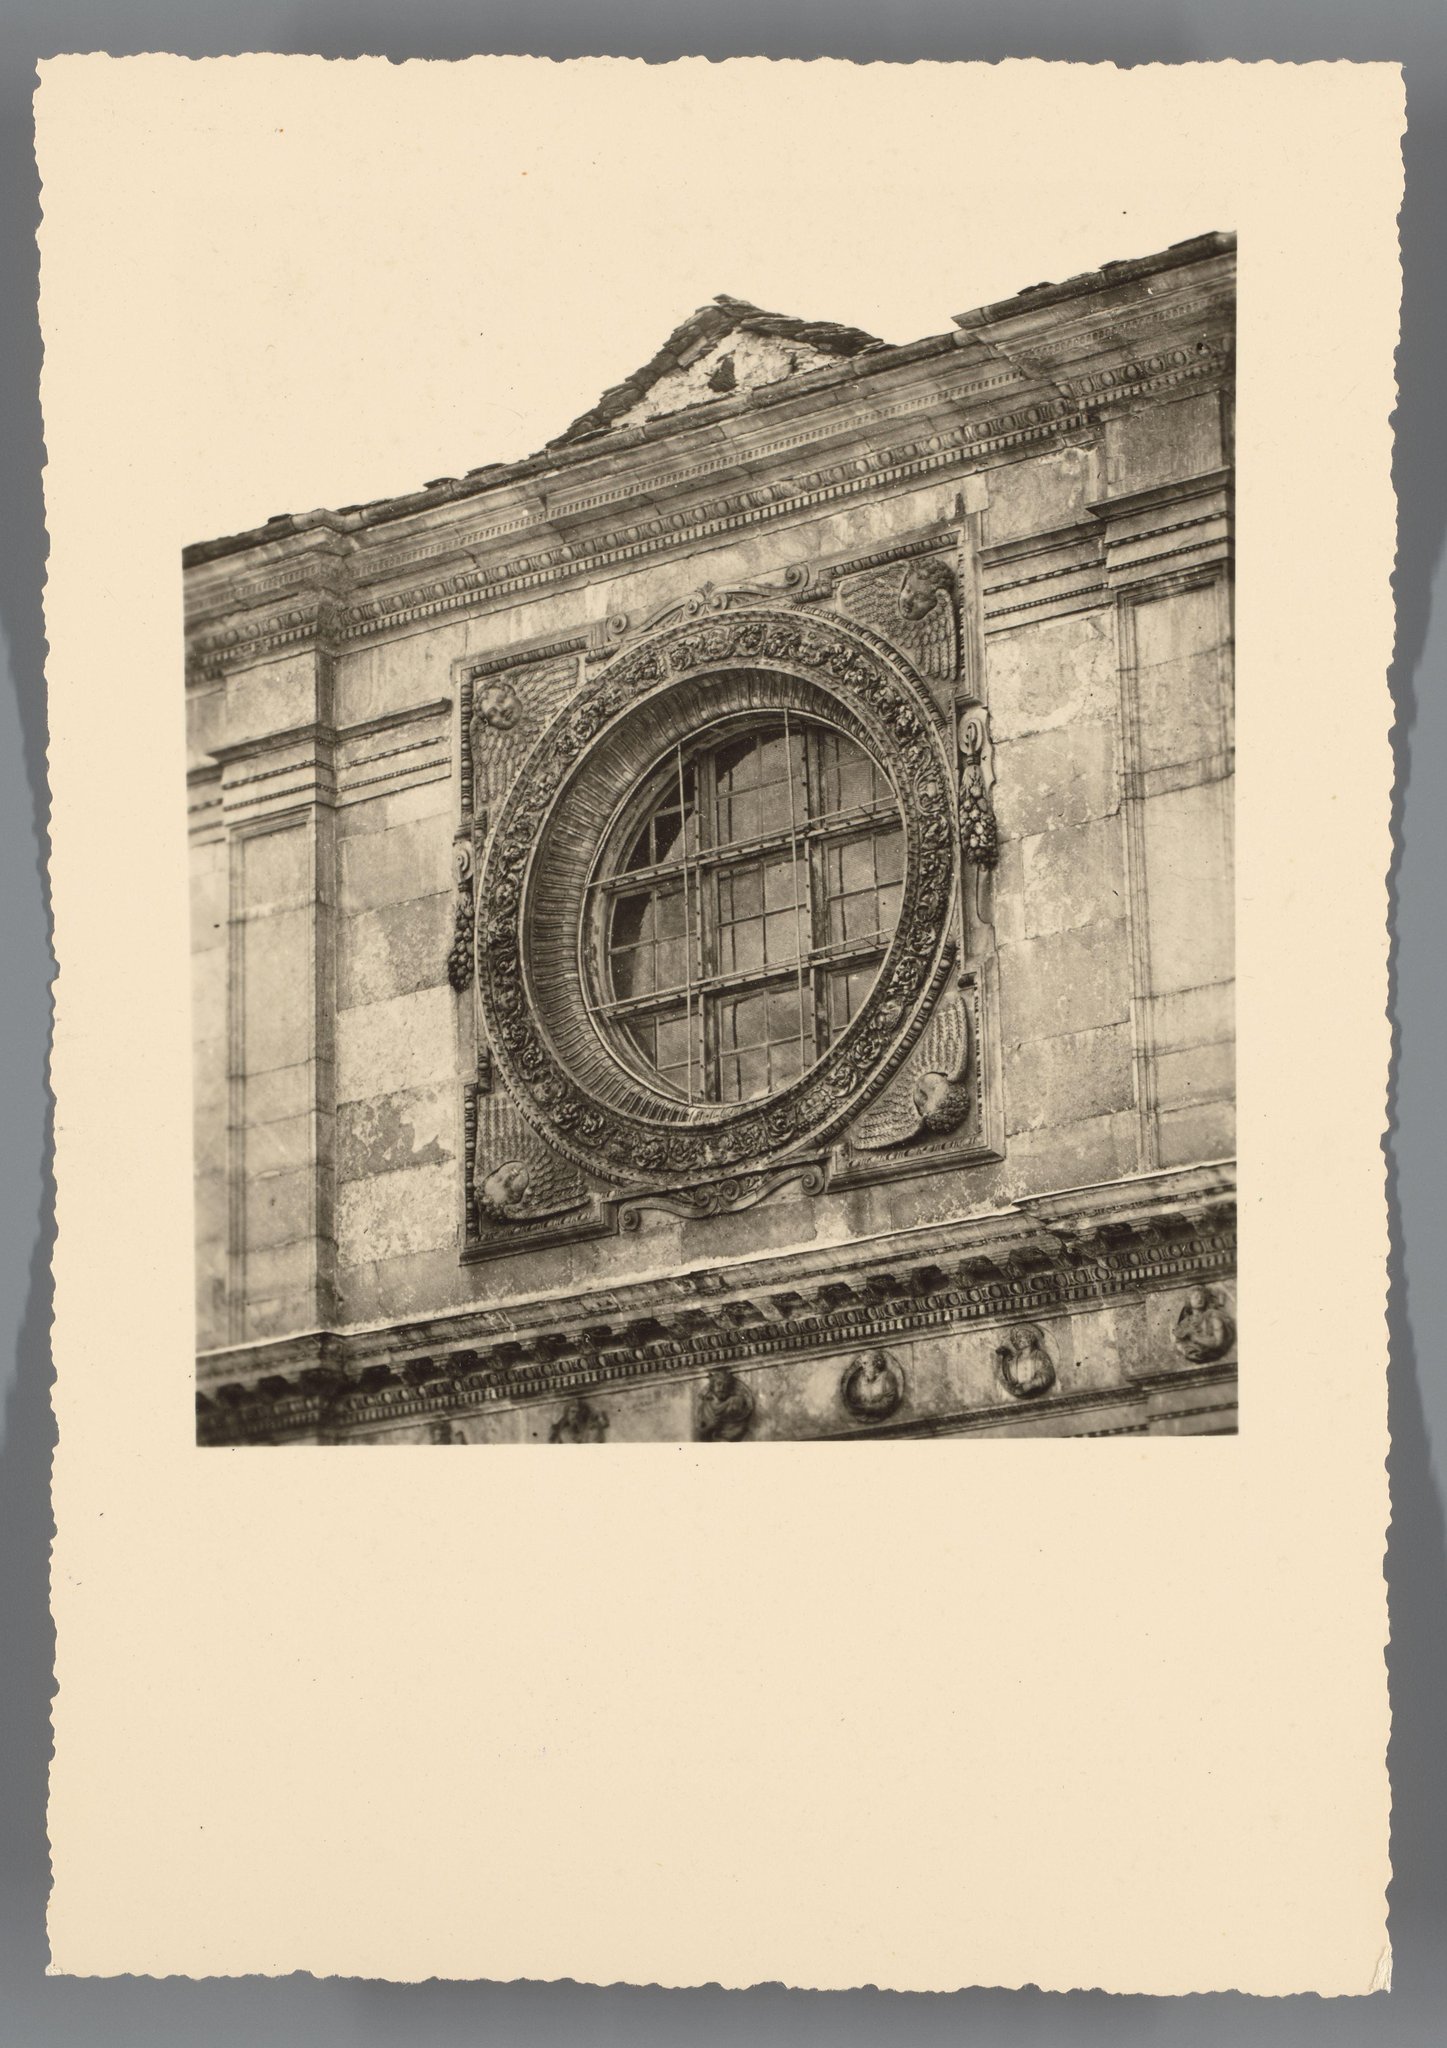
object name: photograph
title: Italië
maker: Anonymous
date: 1880-1910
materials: photographic support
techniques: albumen print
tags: italy